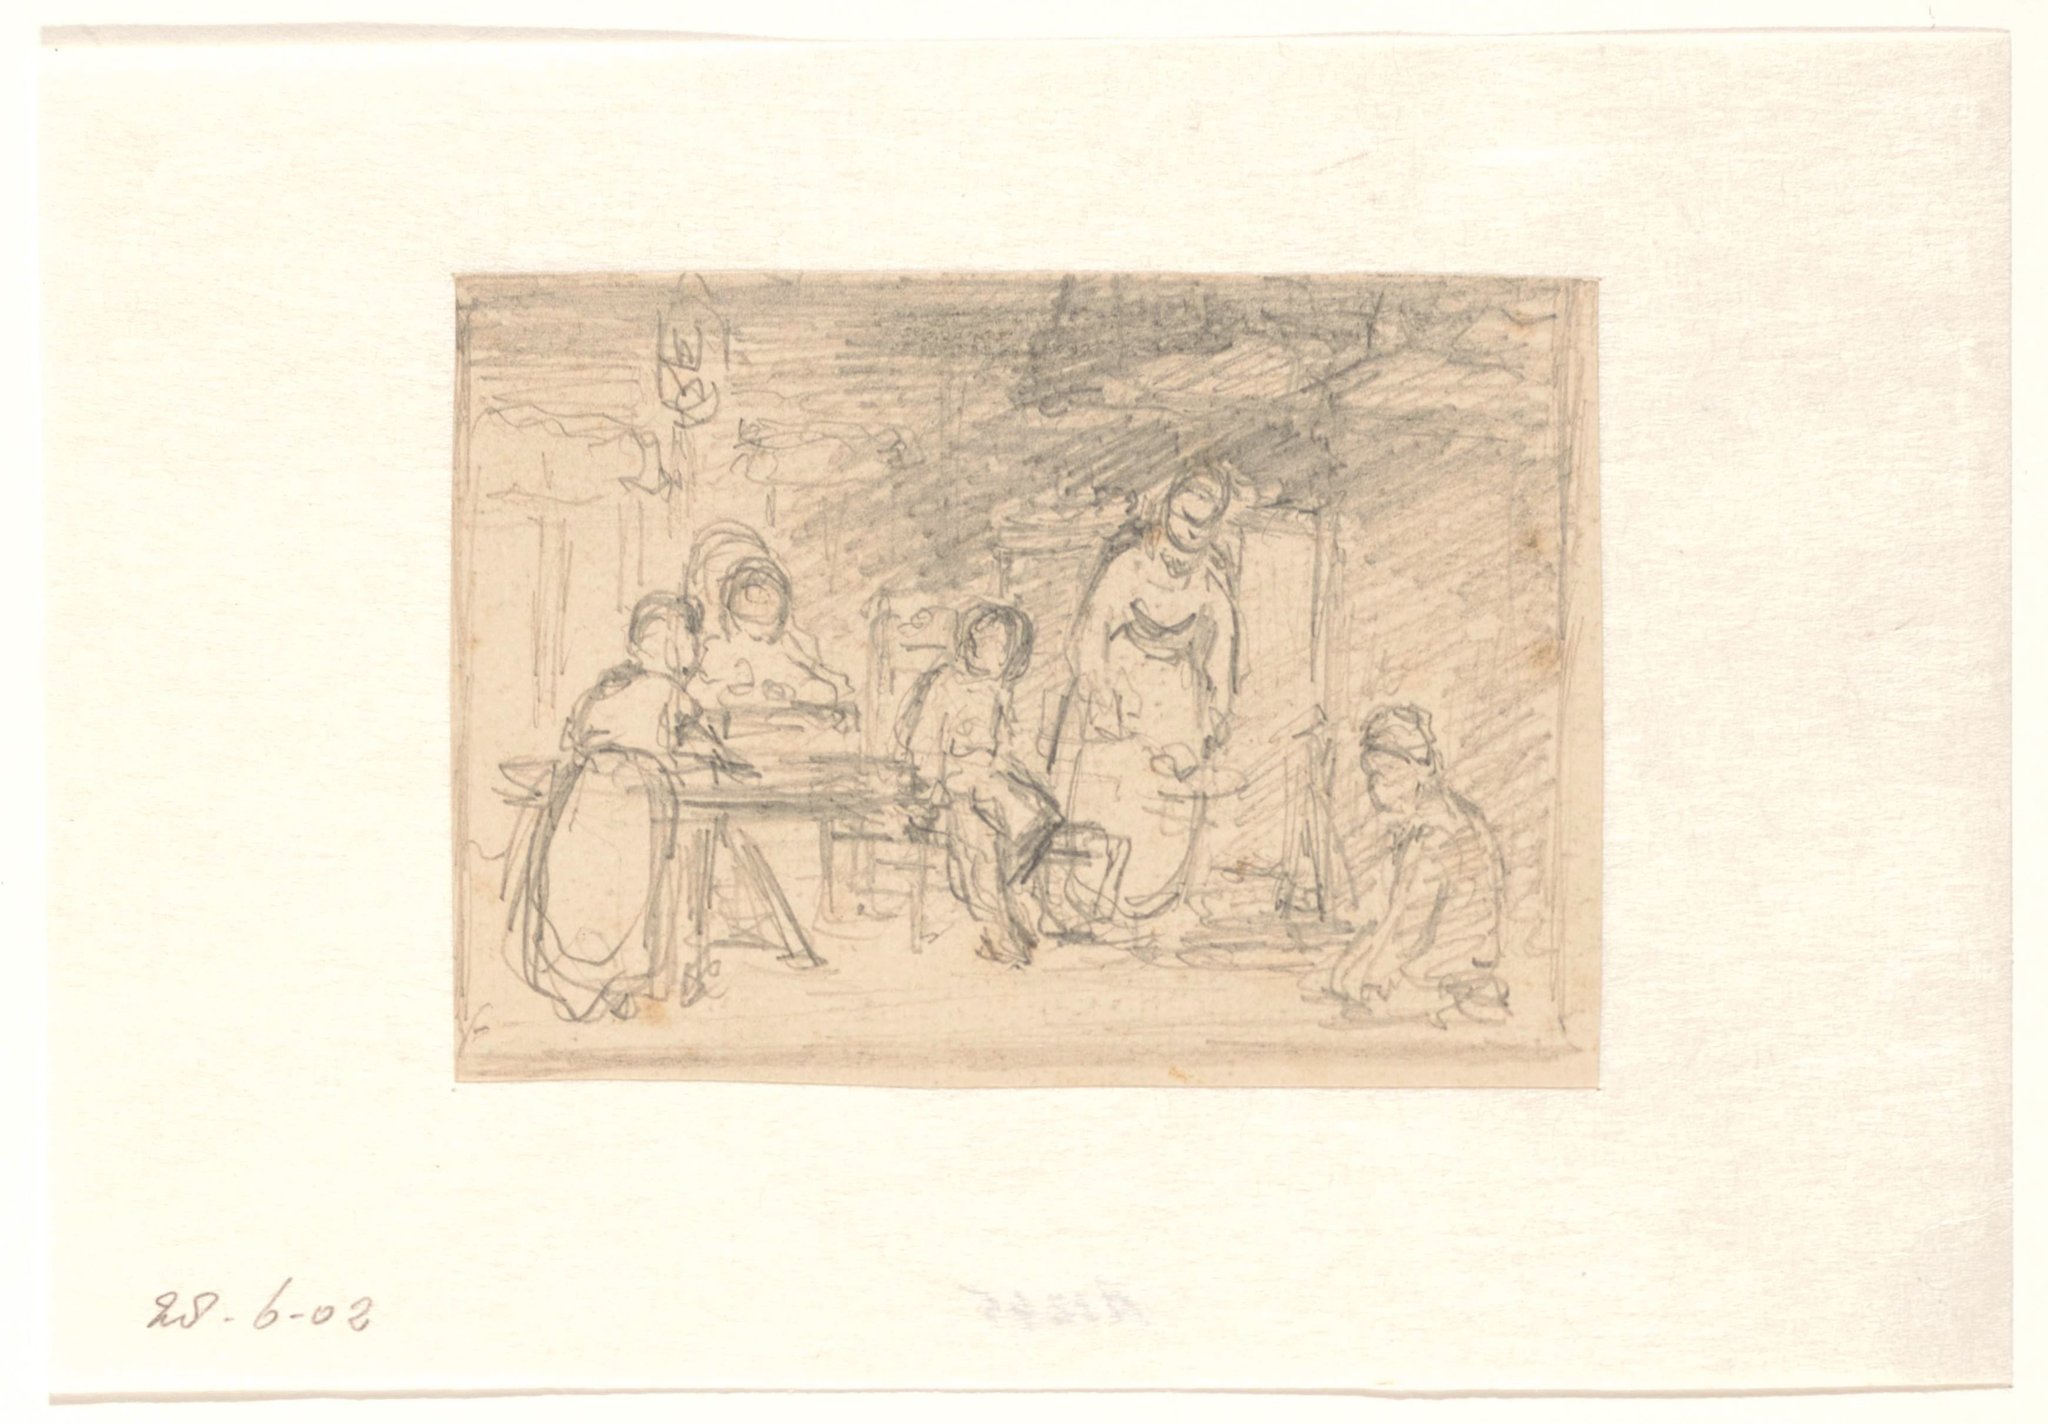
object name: drawing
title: Interieur met vijf personen aan tafel en bij de haard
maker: hendrik valkenburg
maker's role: draughtsman, painter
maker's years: 1826-1896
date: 1836-1896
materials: paper, pencil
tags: family group, especially parents with their child(ren), interior of the house